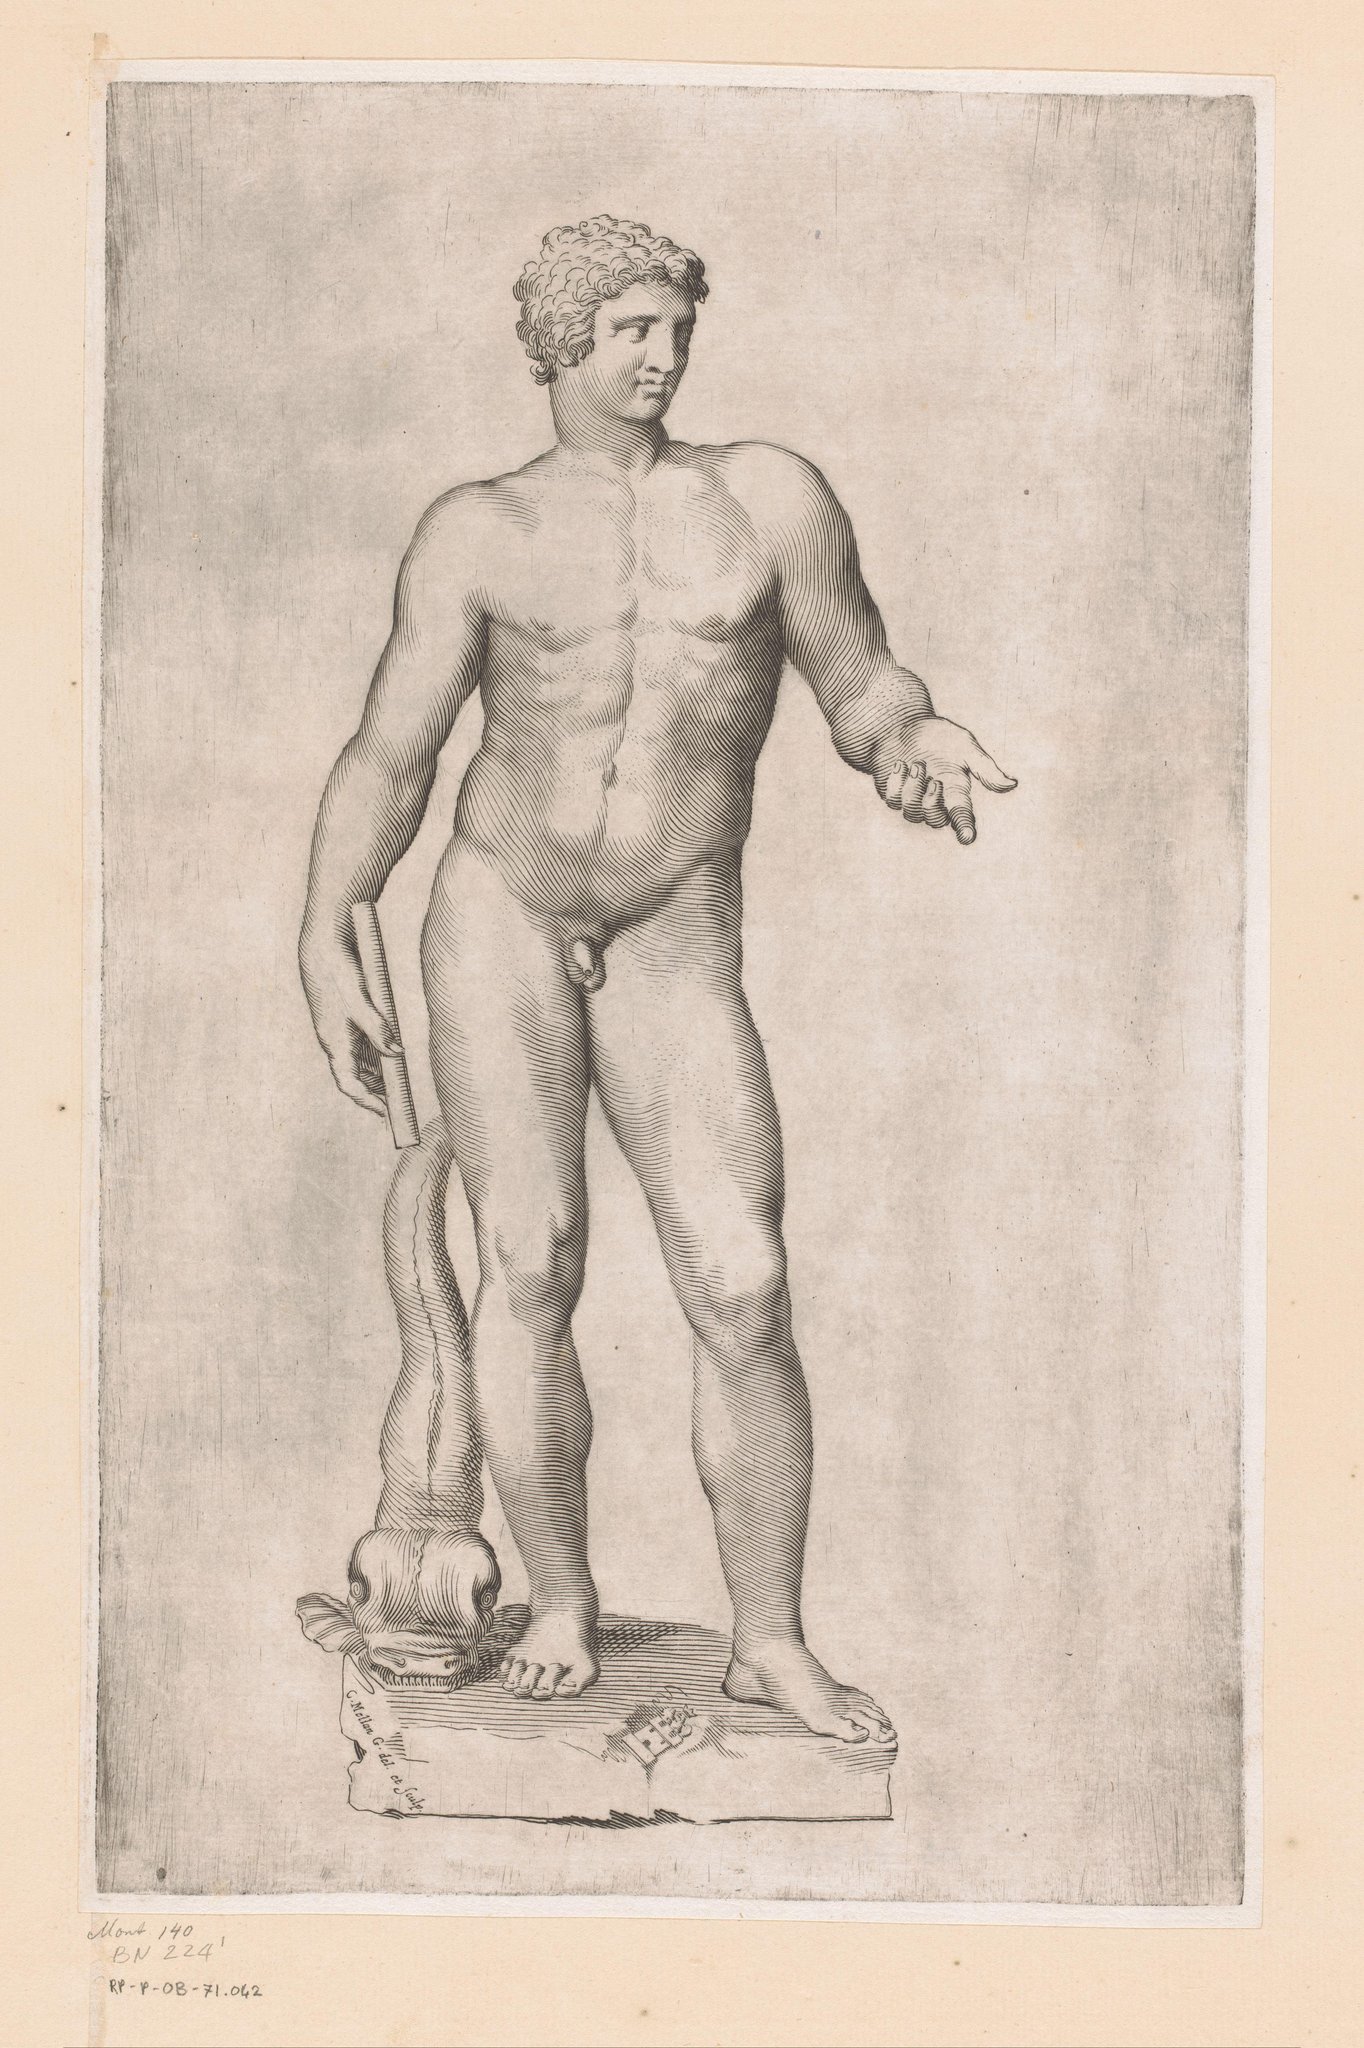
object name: print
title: Standbeeld van een naakte jongeman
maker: claude mellan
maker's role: draughtsman, print maker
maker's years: 1598-1688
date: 1631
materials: paper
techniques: engraving, intaglio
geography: rome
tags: rome, vincenzo giustiniani (1564-1637), piece of sculpture, reproduction of a piece of sculpture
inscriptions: collector's mark: Lugt 240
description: Maakt deel uit van een serie bestaande uit 322 prenten van kunstwerken uit de collectie van Vincenzo Giustiniani die in twee volumes werd uitgegeven door Joachim von Sandrart in 1636 en 1637 (zie British Museum, inv.nr. 1851,1213.565). De serie bestaat uit prenten door verschillende kunstenaars zoals Cornelis Bloemaert, Theodore Matham, Pieter de Bailliu en Michel Natalis. Claude Mellan was verantwoordelijk voor 22 prenten van standbeelden en het 1631 gedateerde portret van Giustiniani.